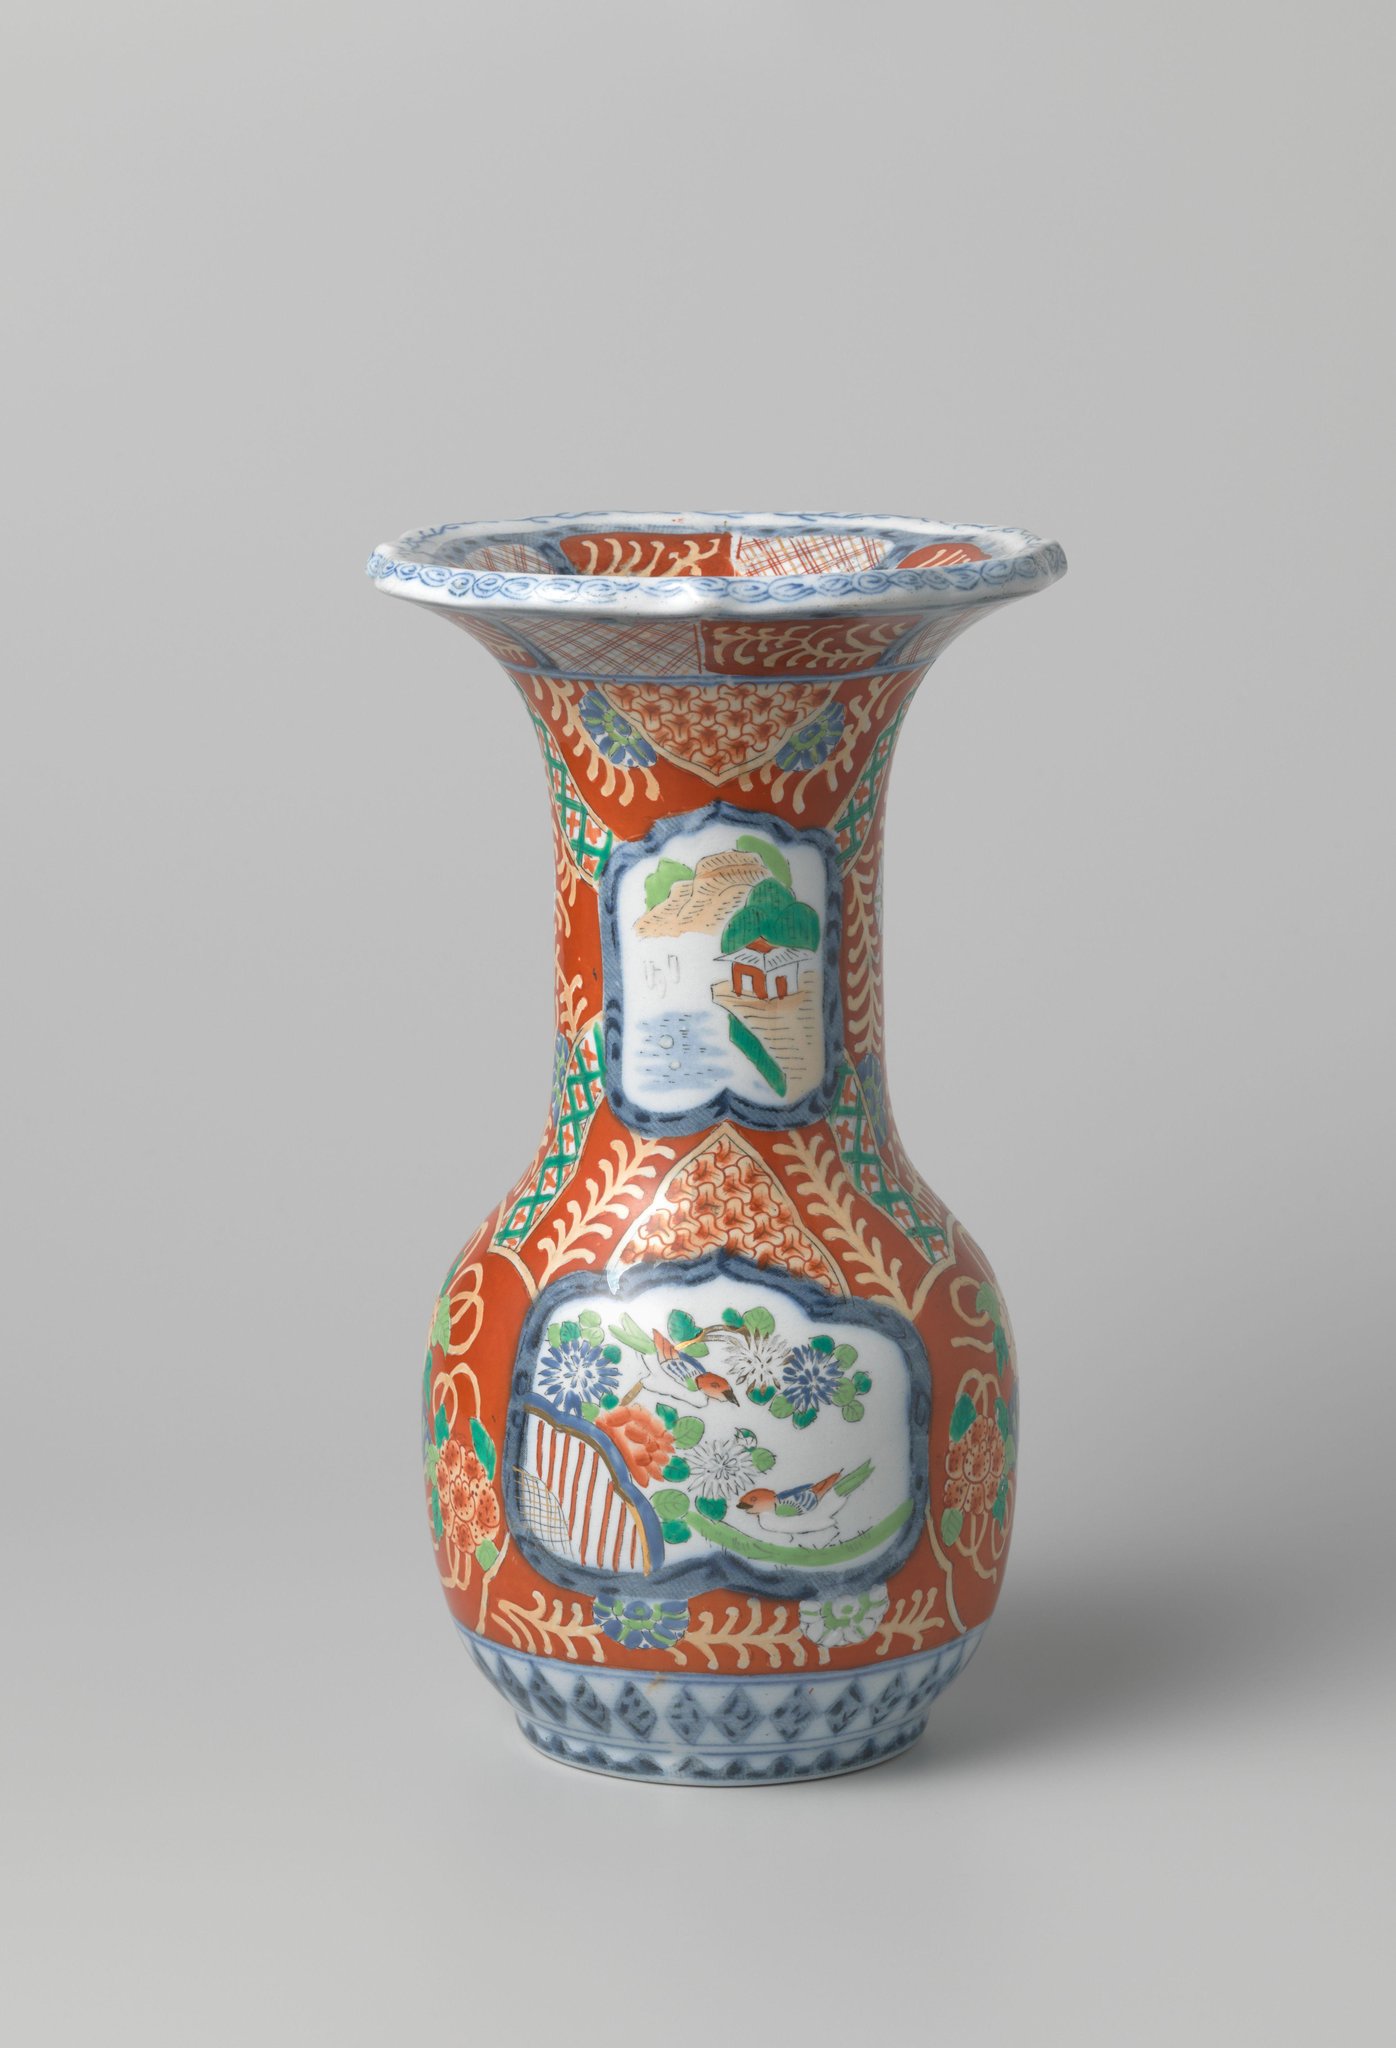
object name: vase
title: Vaas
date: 1886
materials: earthenware, glaze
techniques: vitrification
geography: maastricht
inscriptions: : ‘D 3’, mark: ‘9/X of X/6’, mark: ‘Sfinx // P. REGOUT & Co // MAASTRICHT’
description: Vaas van aardewerk, behorend bij een driedelig kaststel, met zwarte en vloeiblauwe transferdecoratie, beschilderd met emailkleuren en okerluster, met goud gehoogd. Op de buik twee cartouches met vogels en takken, op de hals twee cartouches met een landschap.